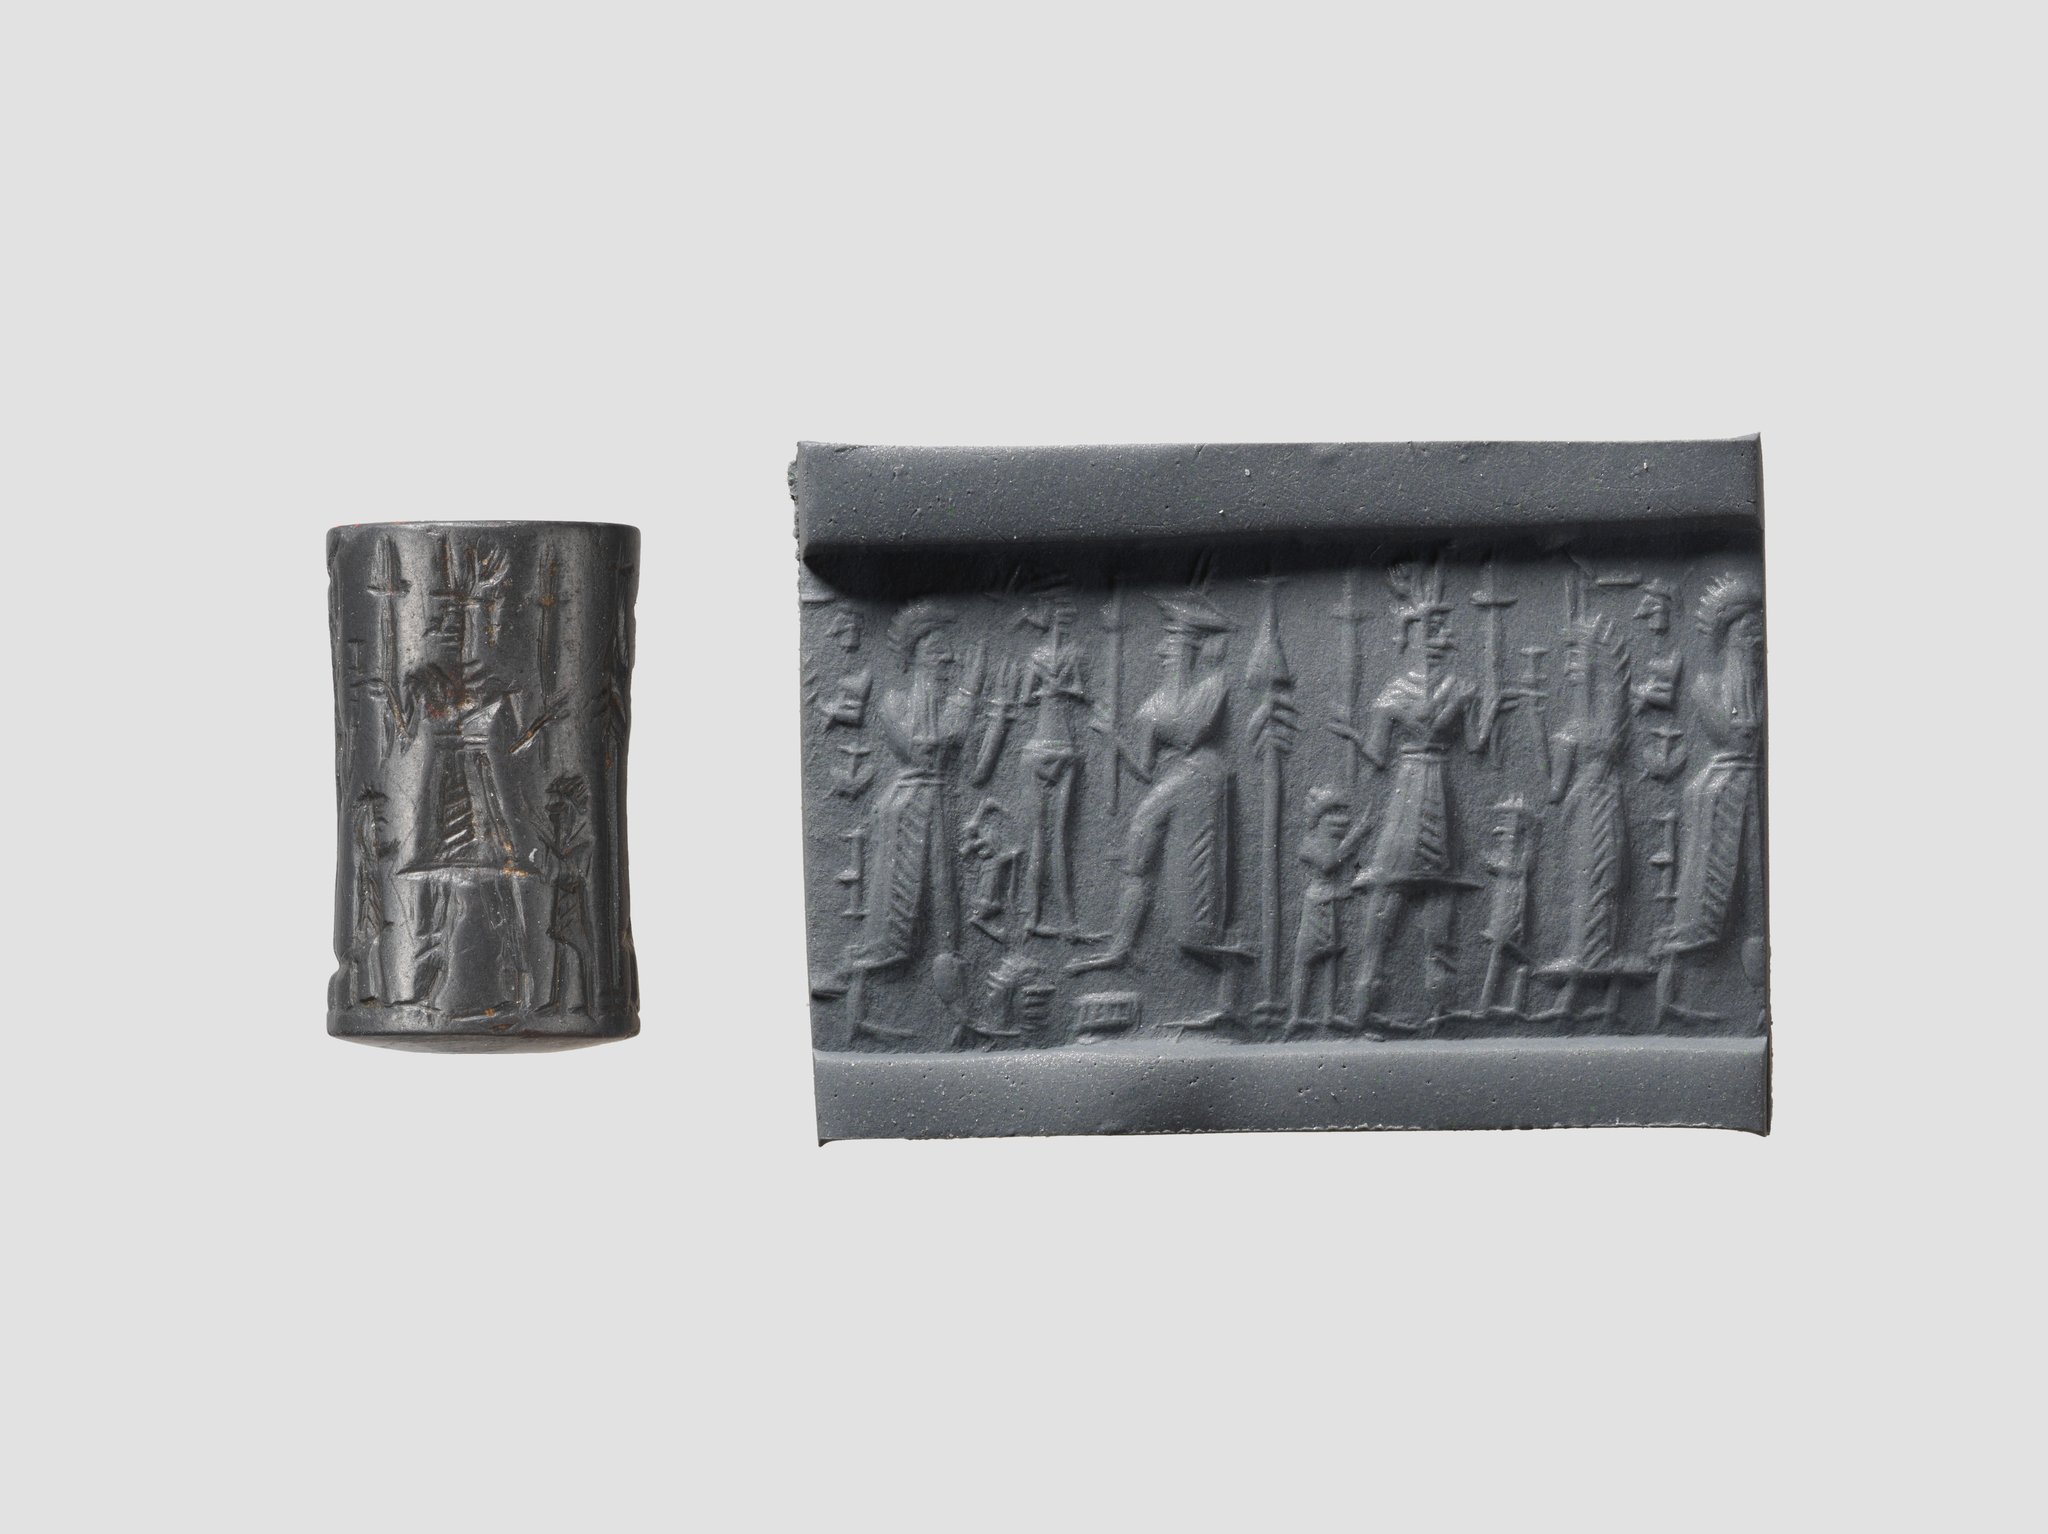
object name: cylinder seal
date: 1820-1730 BCE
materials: mineral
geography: syria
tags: men